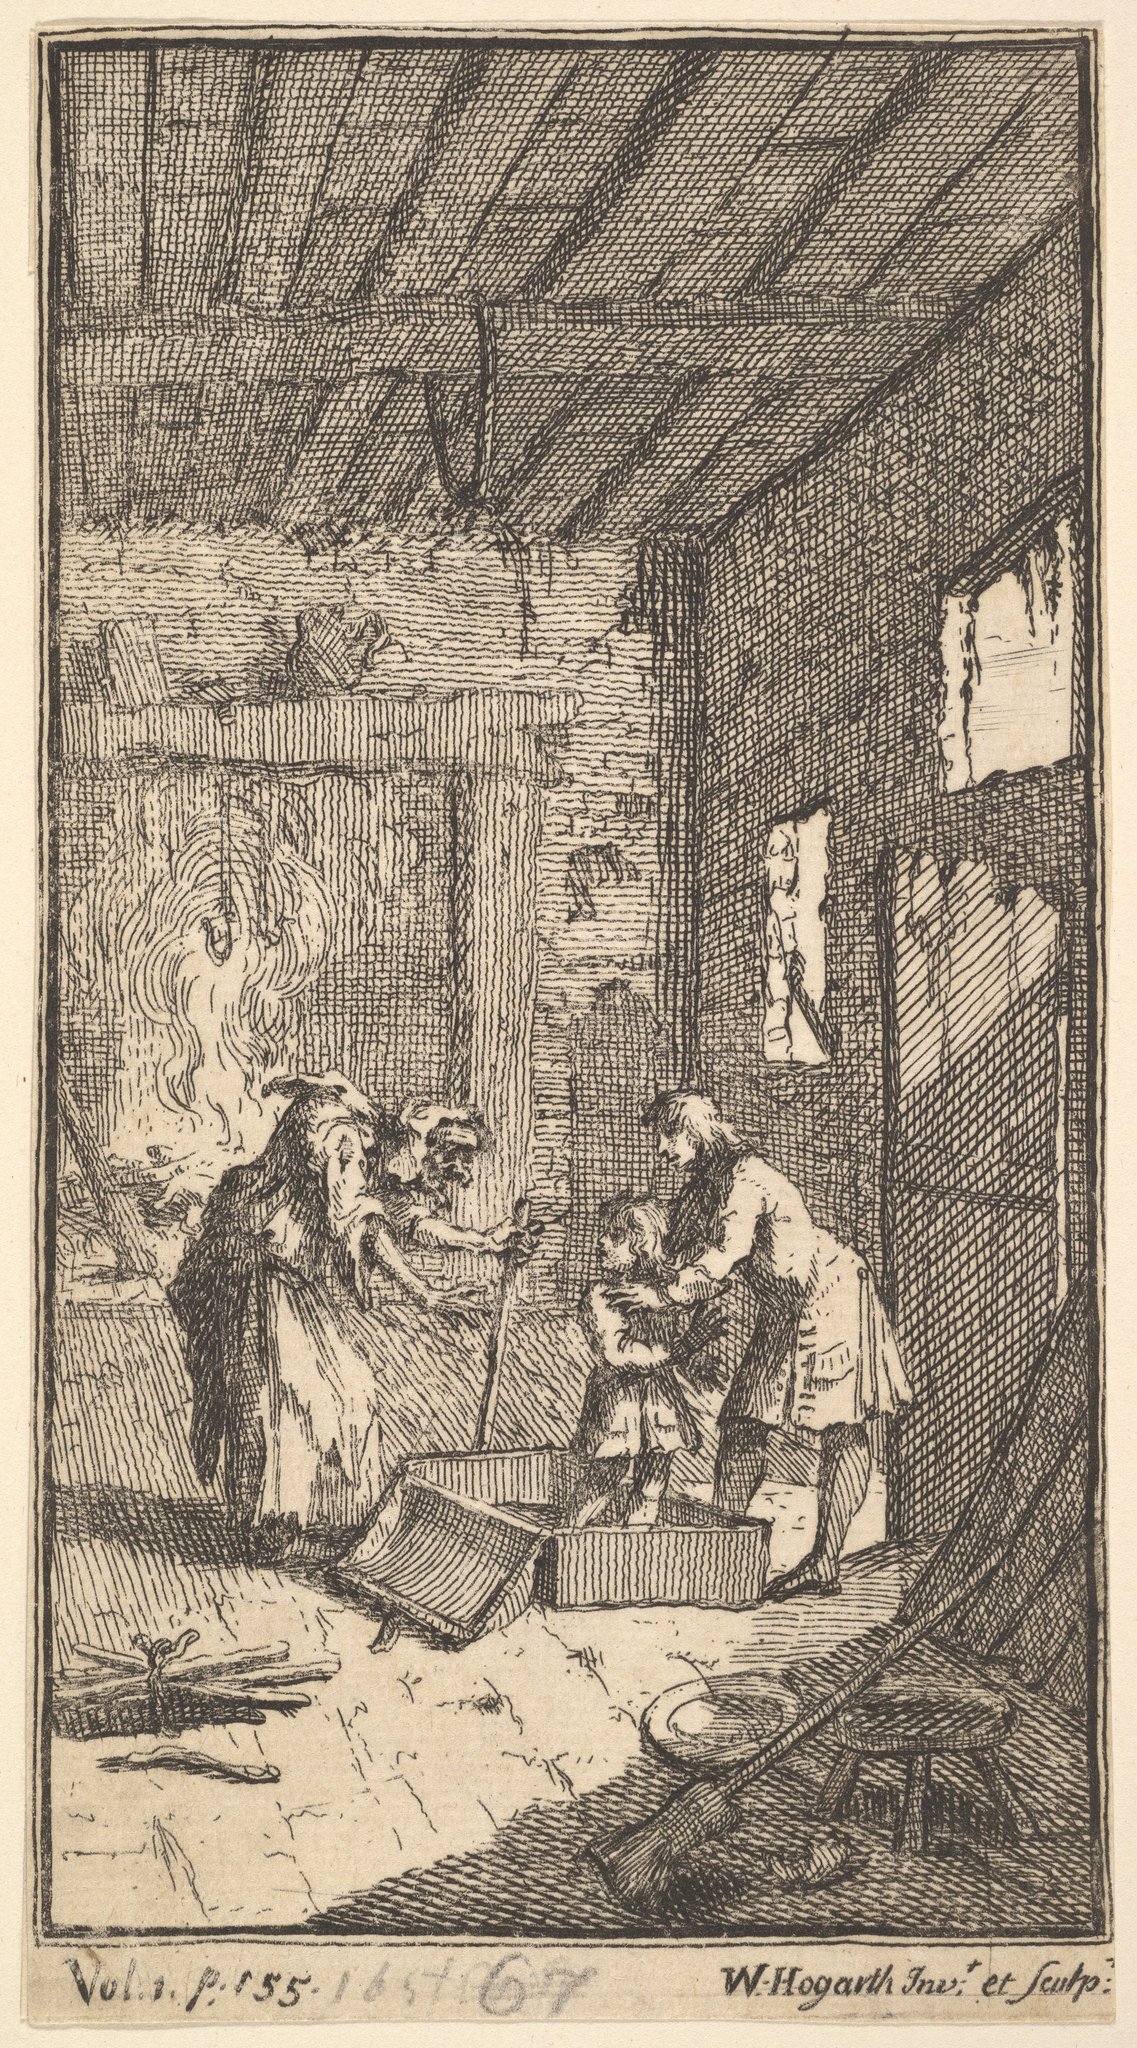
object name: print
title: The New Metamorphosis, Plate 4: Invidiosa Releases Fantasio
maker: william hogarth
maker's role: artist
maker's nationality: british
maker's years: 1697-1764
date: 1724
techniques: engraving, etching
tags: girls,men,women